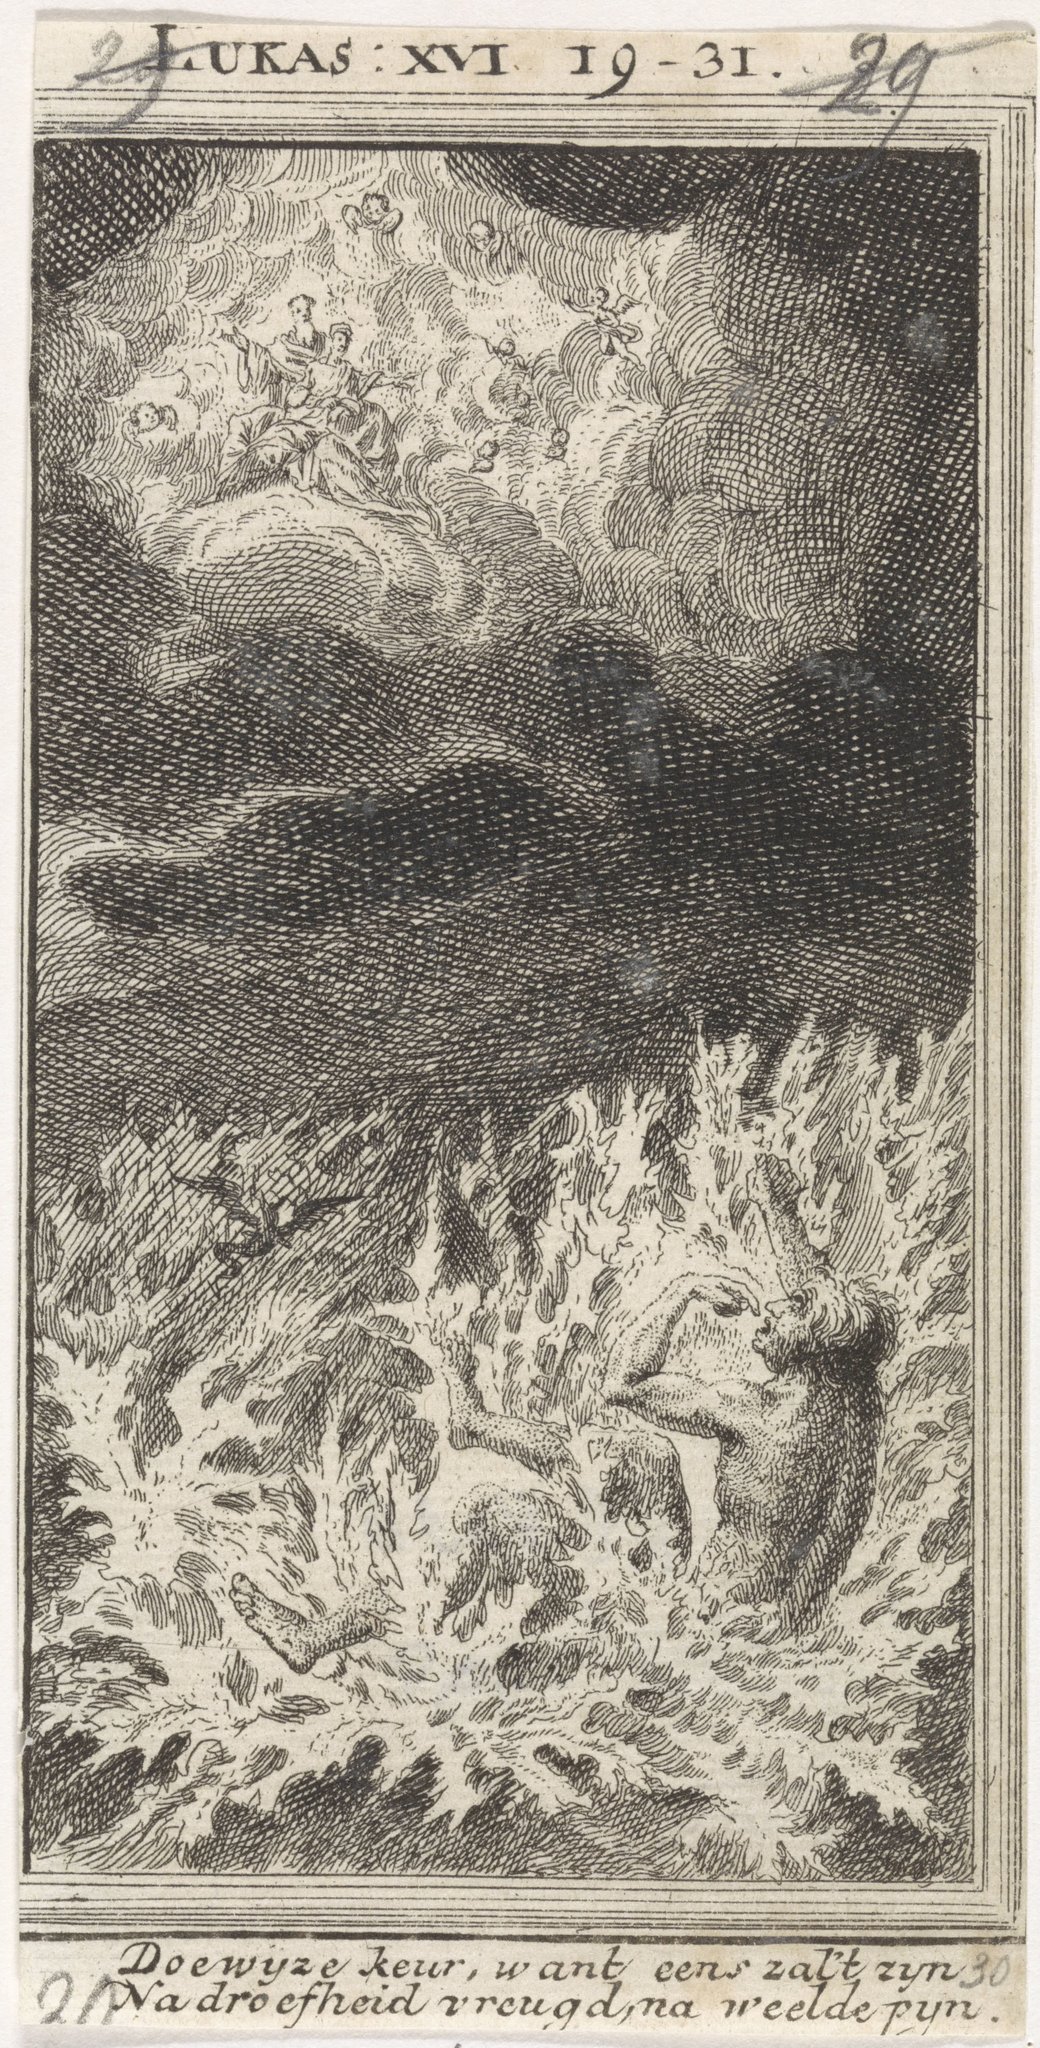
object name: print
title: Lazarus in Abrahams schoot en de rijke man in de hel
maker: Anonymous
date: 1712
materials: paper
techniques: etching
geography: amsterdam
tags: the rich man (dives) is feasting, while poor lazarus is starving at the gate (dogs licking lazarus' sores) (luke 16:19-31)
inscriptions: collector's mark: Lugt 2228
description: Kopie van illustratie voor: Luyken, Jan. Bybel printen. Amsterdam: Pieter Arentsz. II (wed.) en Cornelis van der Sys, 1712, p. 29.